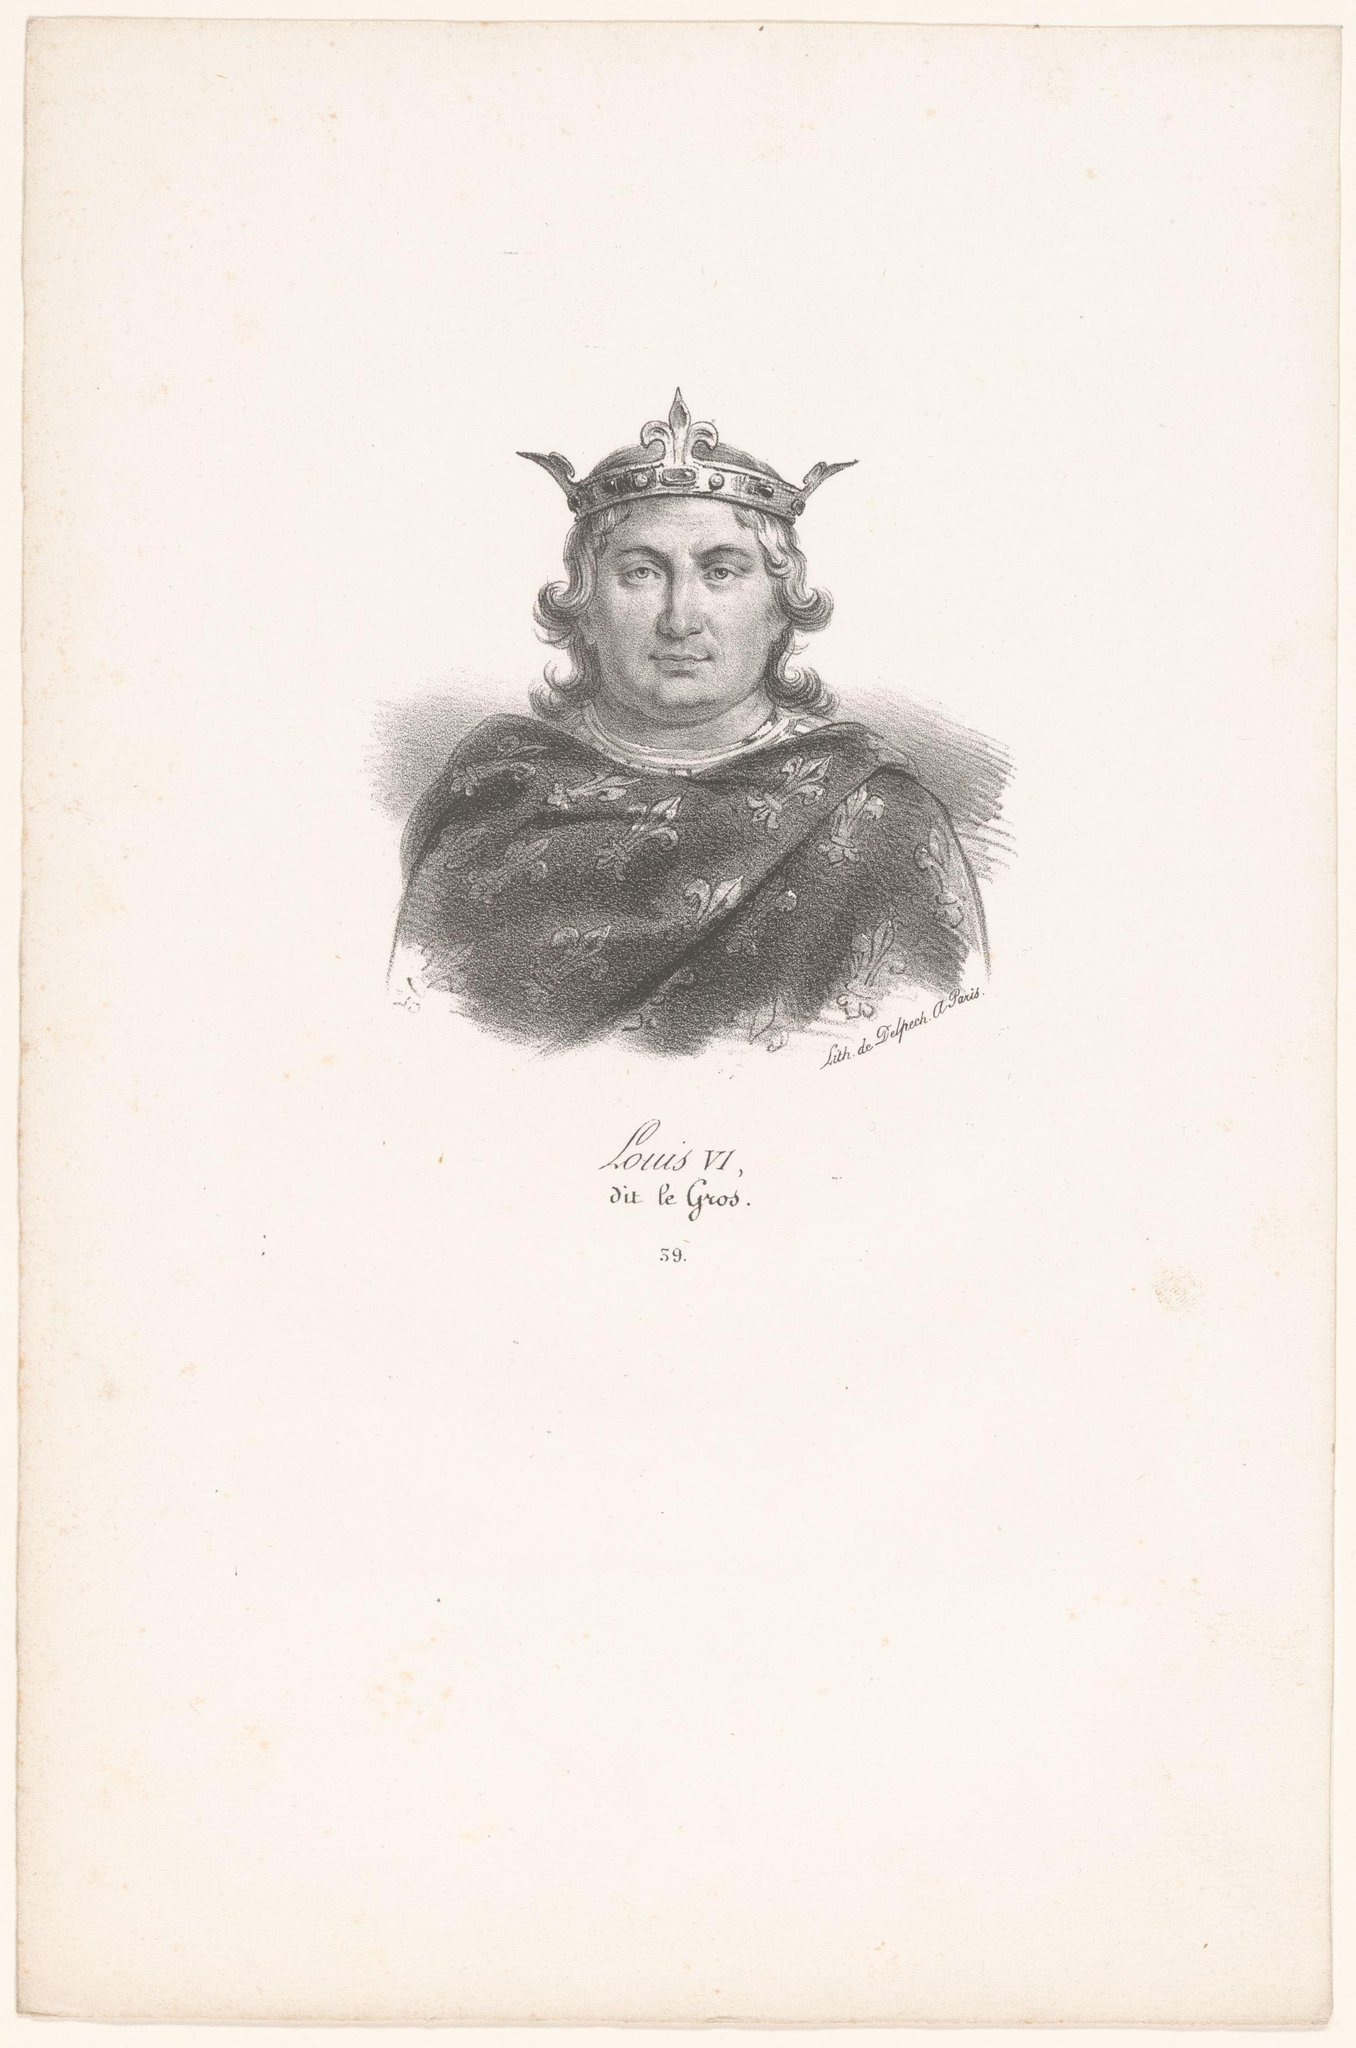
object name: print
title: Portret van Lodewijk VI van Frankrijk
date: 1818-1842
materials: paper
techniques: lithograph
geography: paris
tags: paris, historical persons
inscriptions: collector's mark: Lugt 2228a